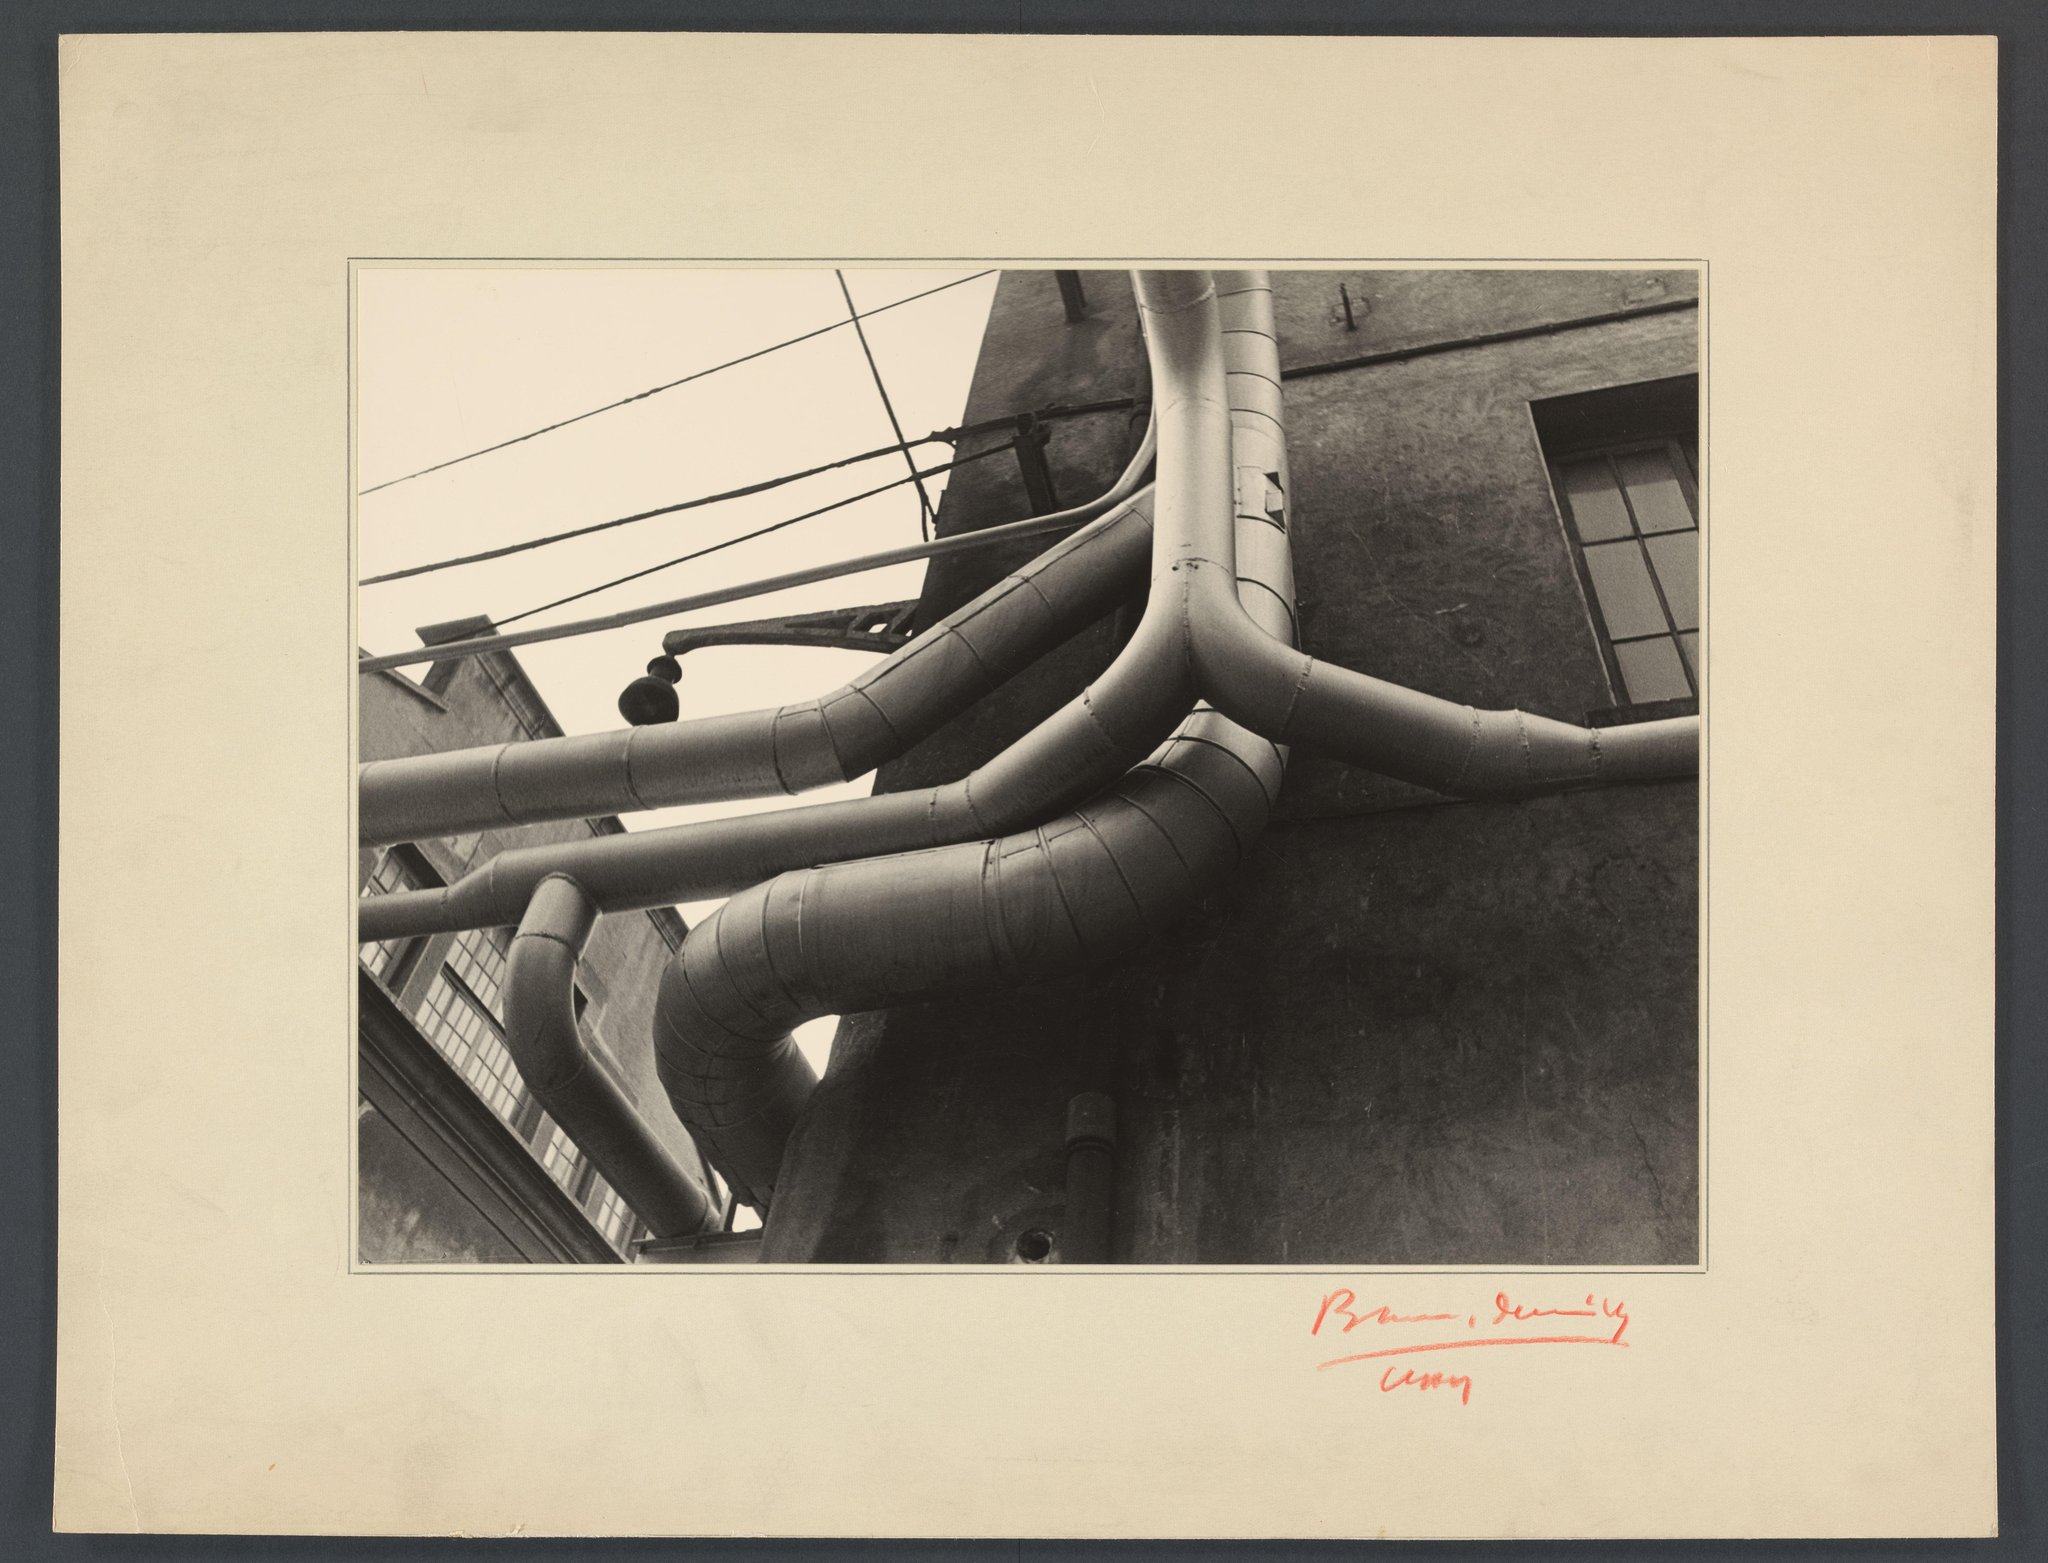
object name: photograph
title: Buizenstelsel aan een gebouw in Lyon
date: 1935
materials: paper, cardboard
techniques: gelatin silver print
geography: lyon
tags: water-supply and draining, pipework (in house or building), lyon